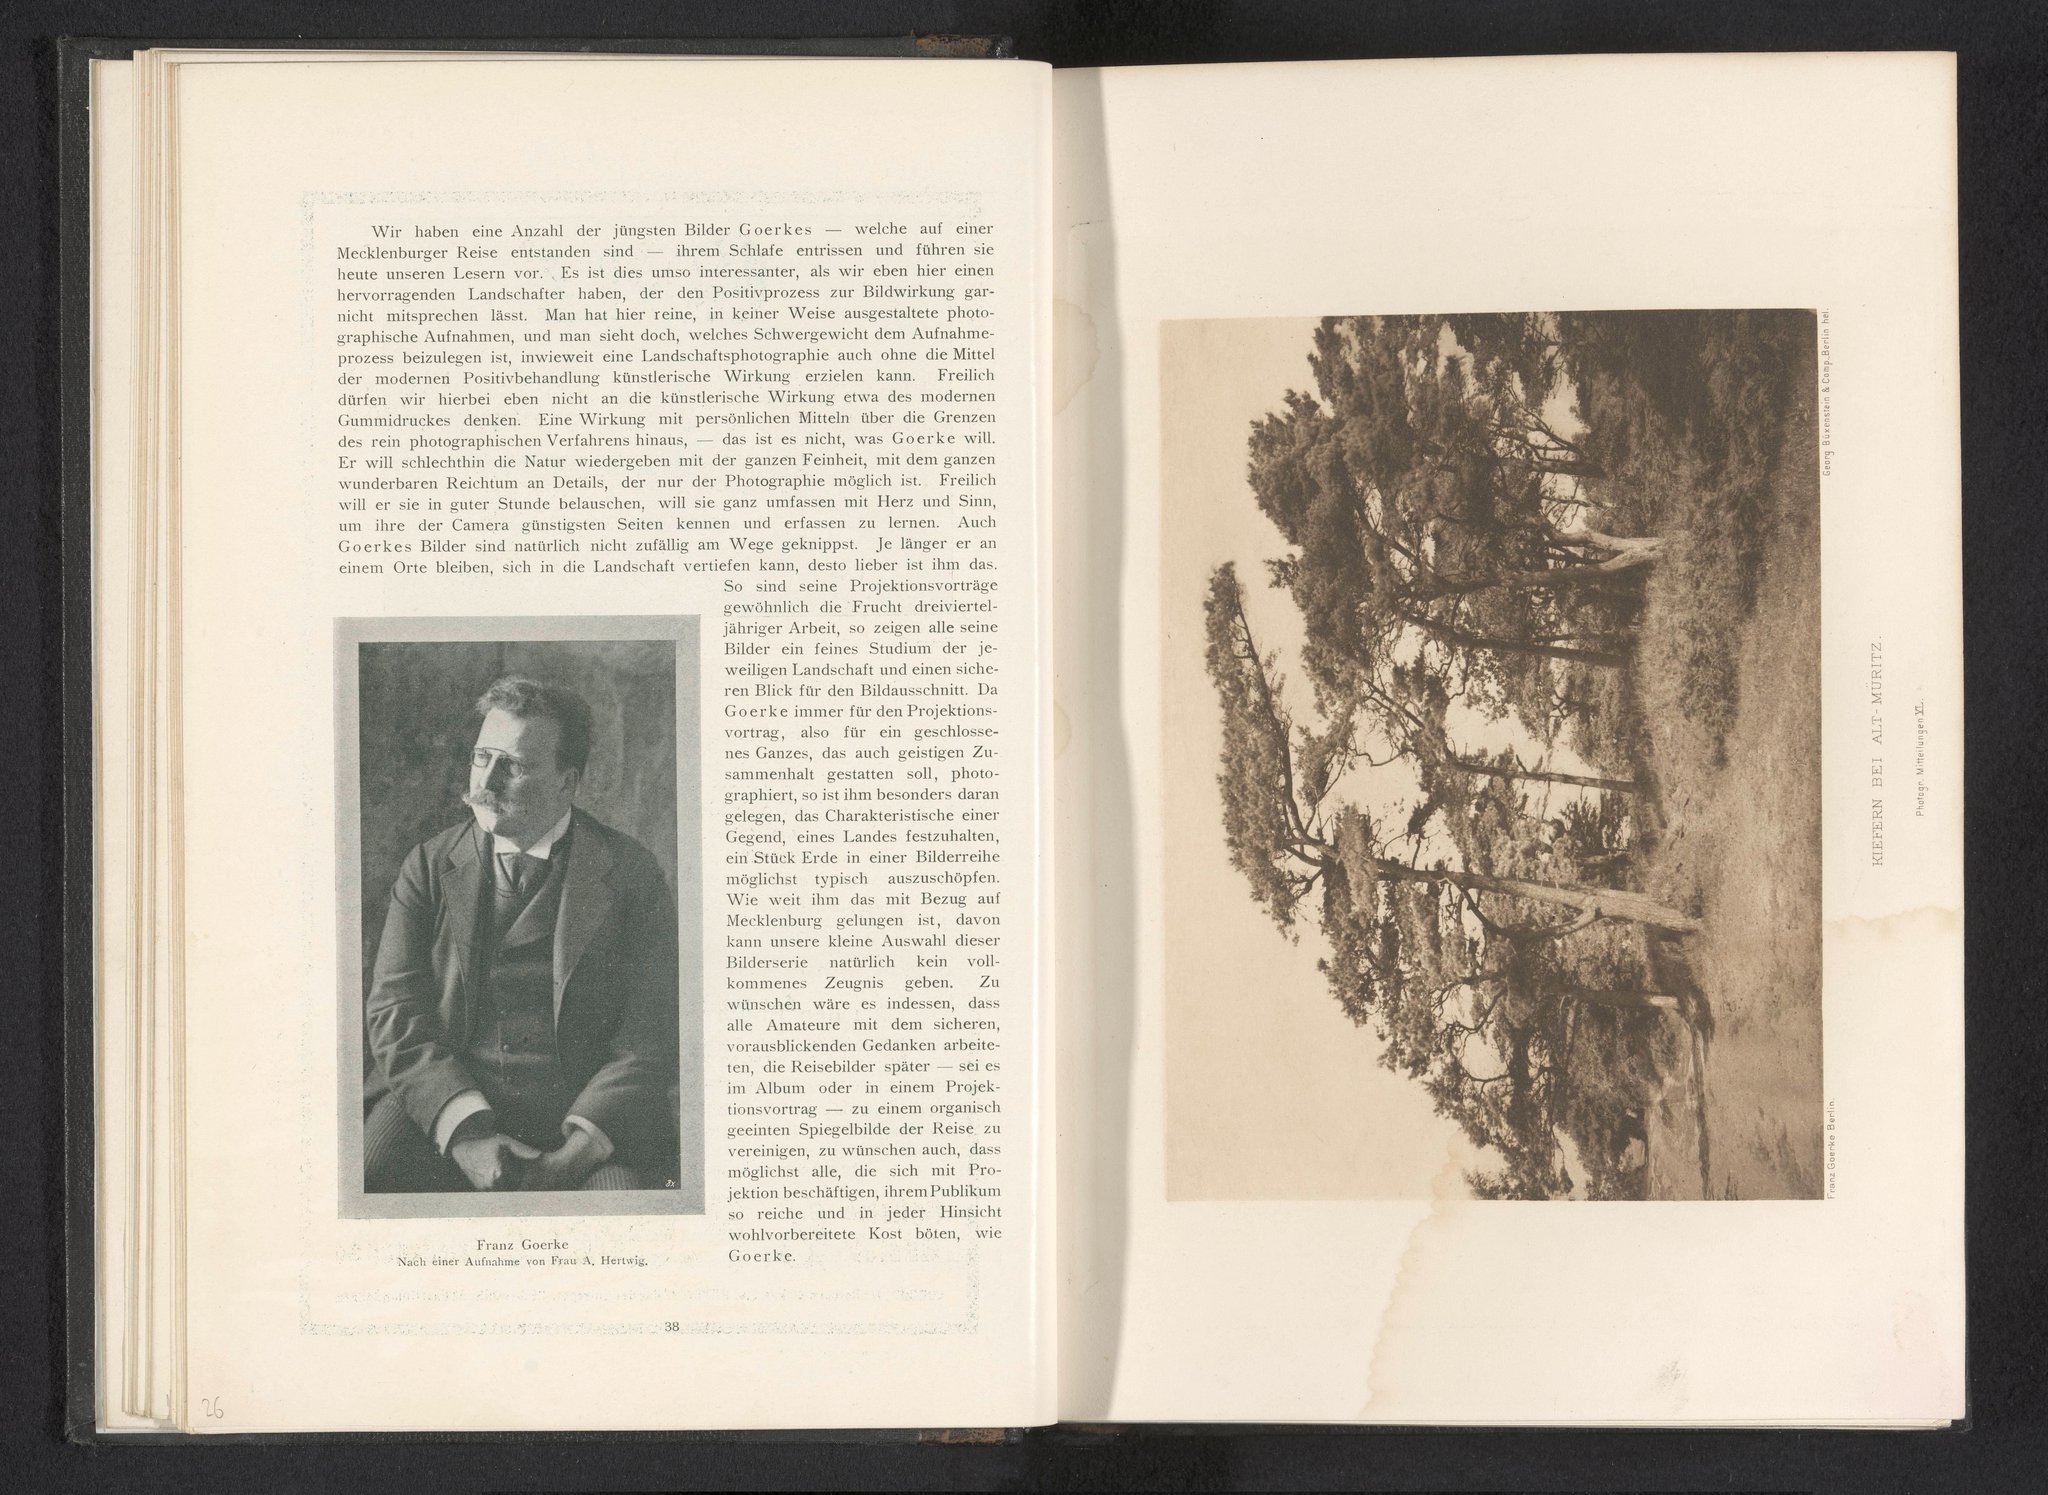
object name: page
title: Franz Goerke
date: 1898-1903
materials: paper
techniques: autotype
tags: berlin, franz goerke, historical persons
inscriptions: monogram: ‘BX’, inscription: ‘Nach einer Aufnahme von Frau A. Hertwig’